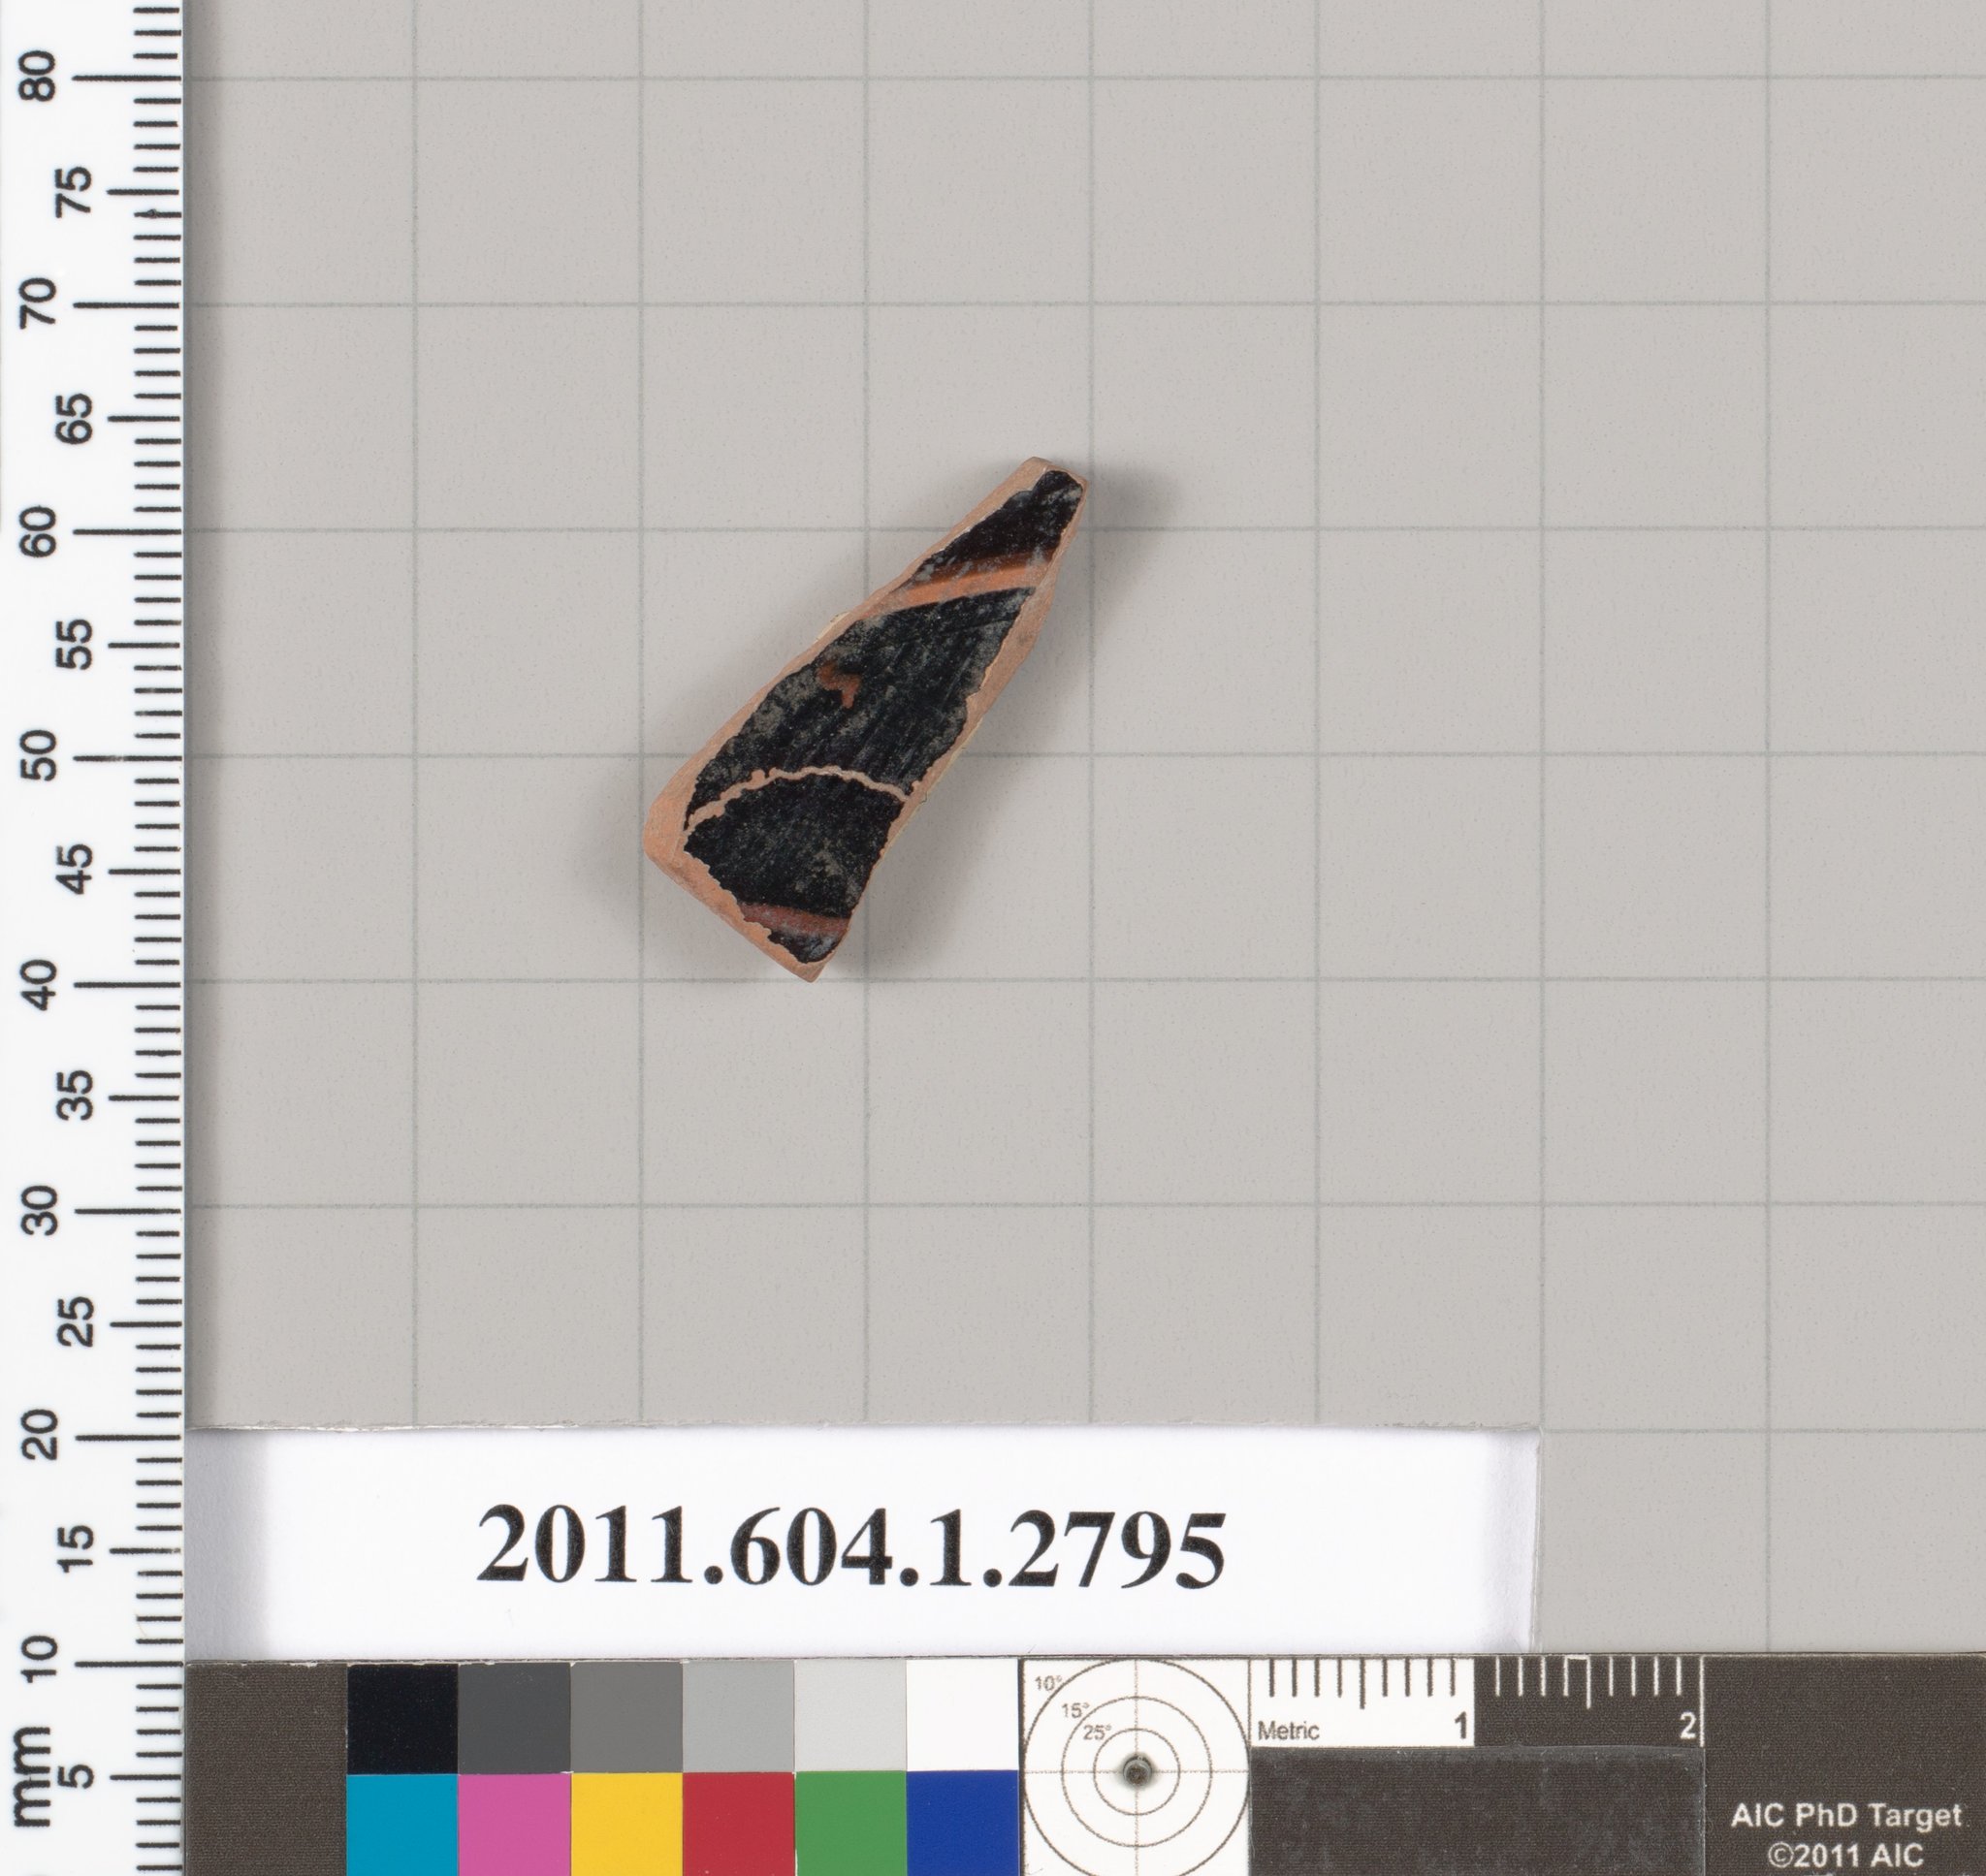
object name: kylix fragment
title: Terracotta fragment of a kylix (drinking cup)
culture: greek, attic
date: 520-500 BCE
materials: terracotta